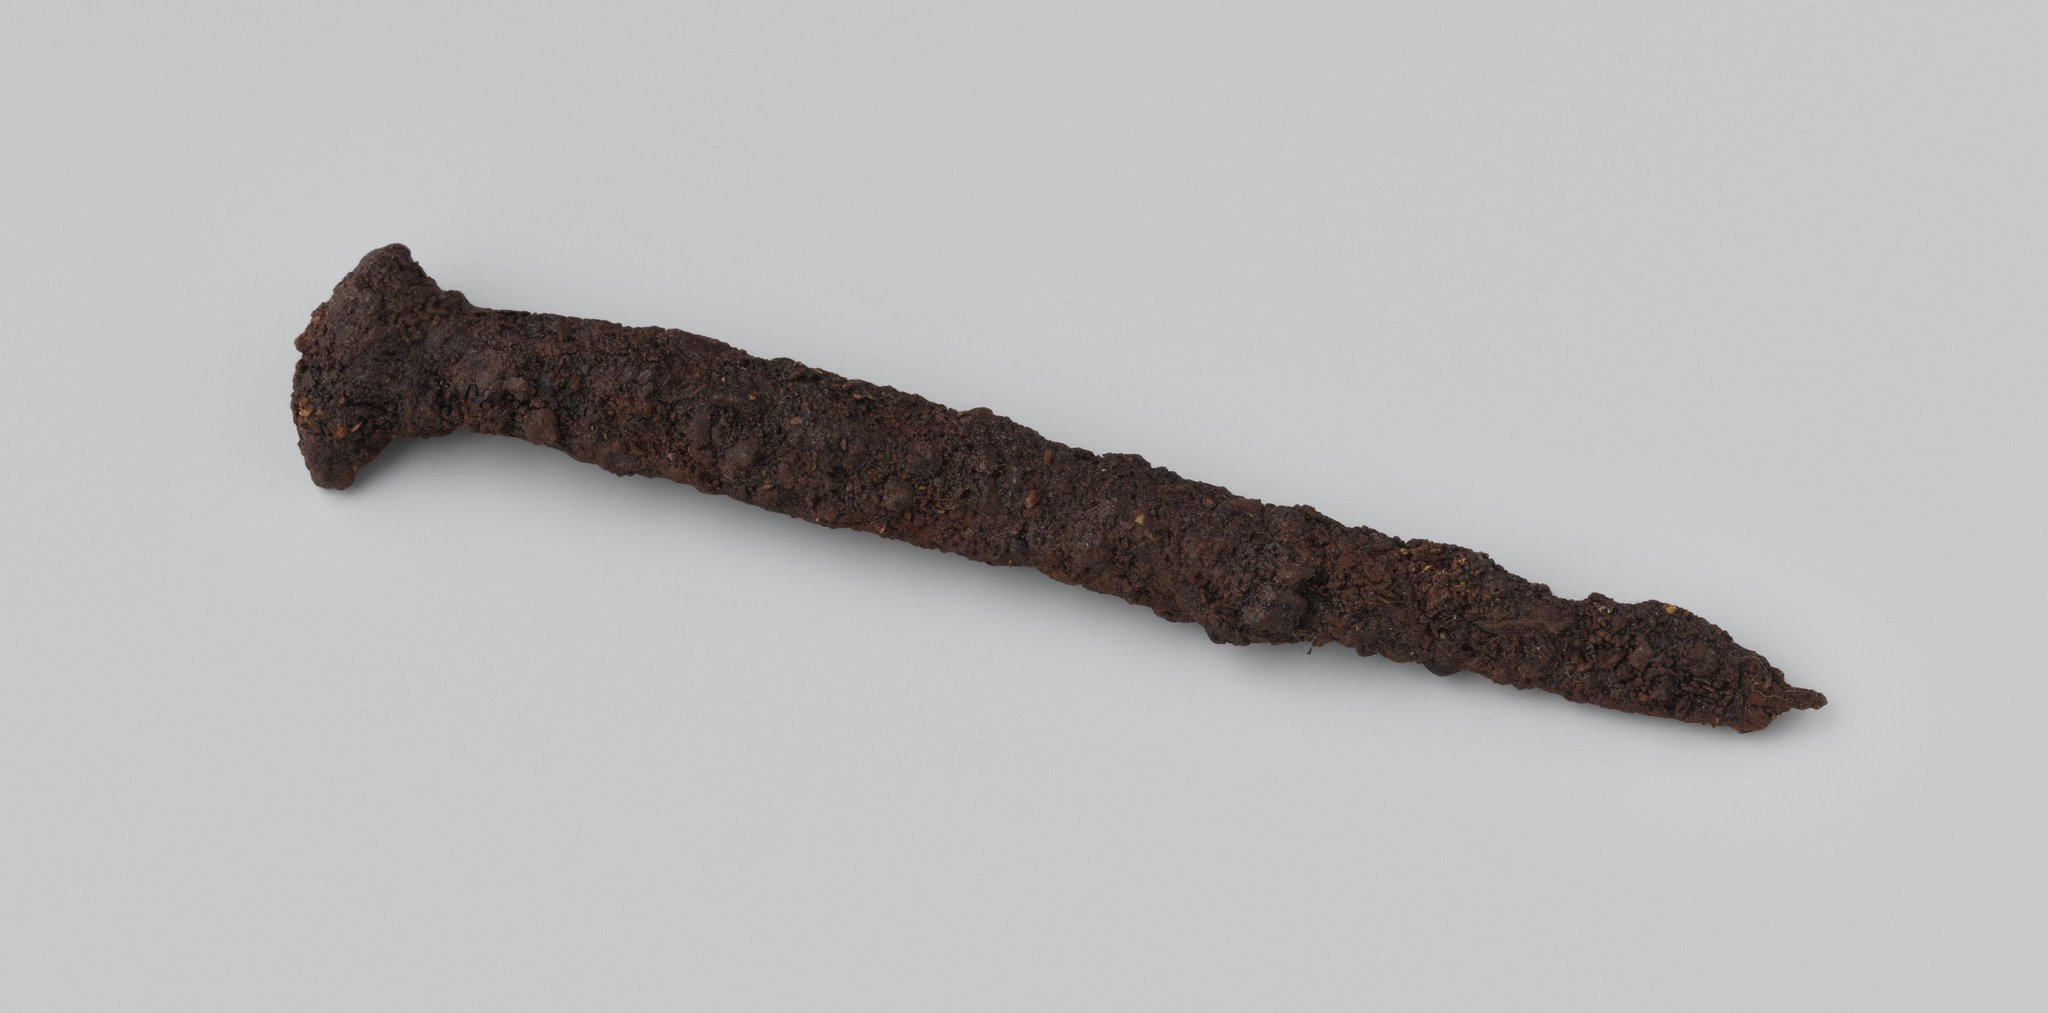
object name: nagel, spijker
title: Spijker afkomstig uit het wrak van de Oost-Indiëvaarder Hollandia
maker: Anonymous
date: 1700-1743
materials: iron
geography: netherlands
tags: verenigde oostindische compagnie, hollandia (schip)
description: Nails; corroded, sim. 80H1245, head probably faceted.